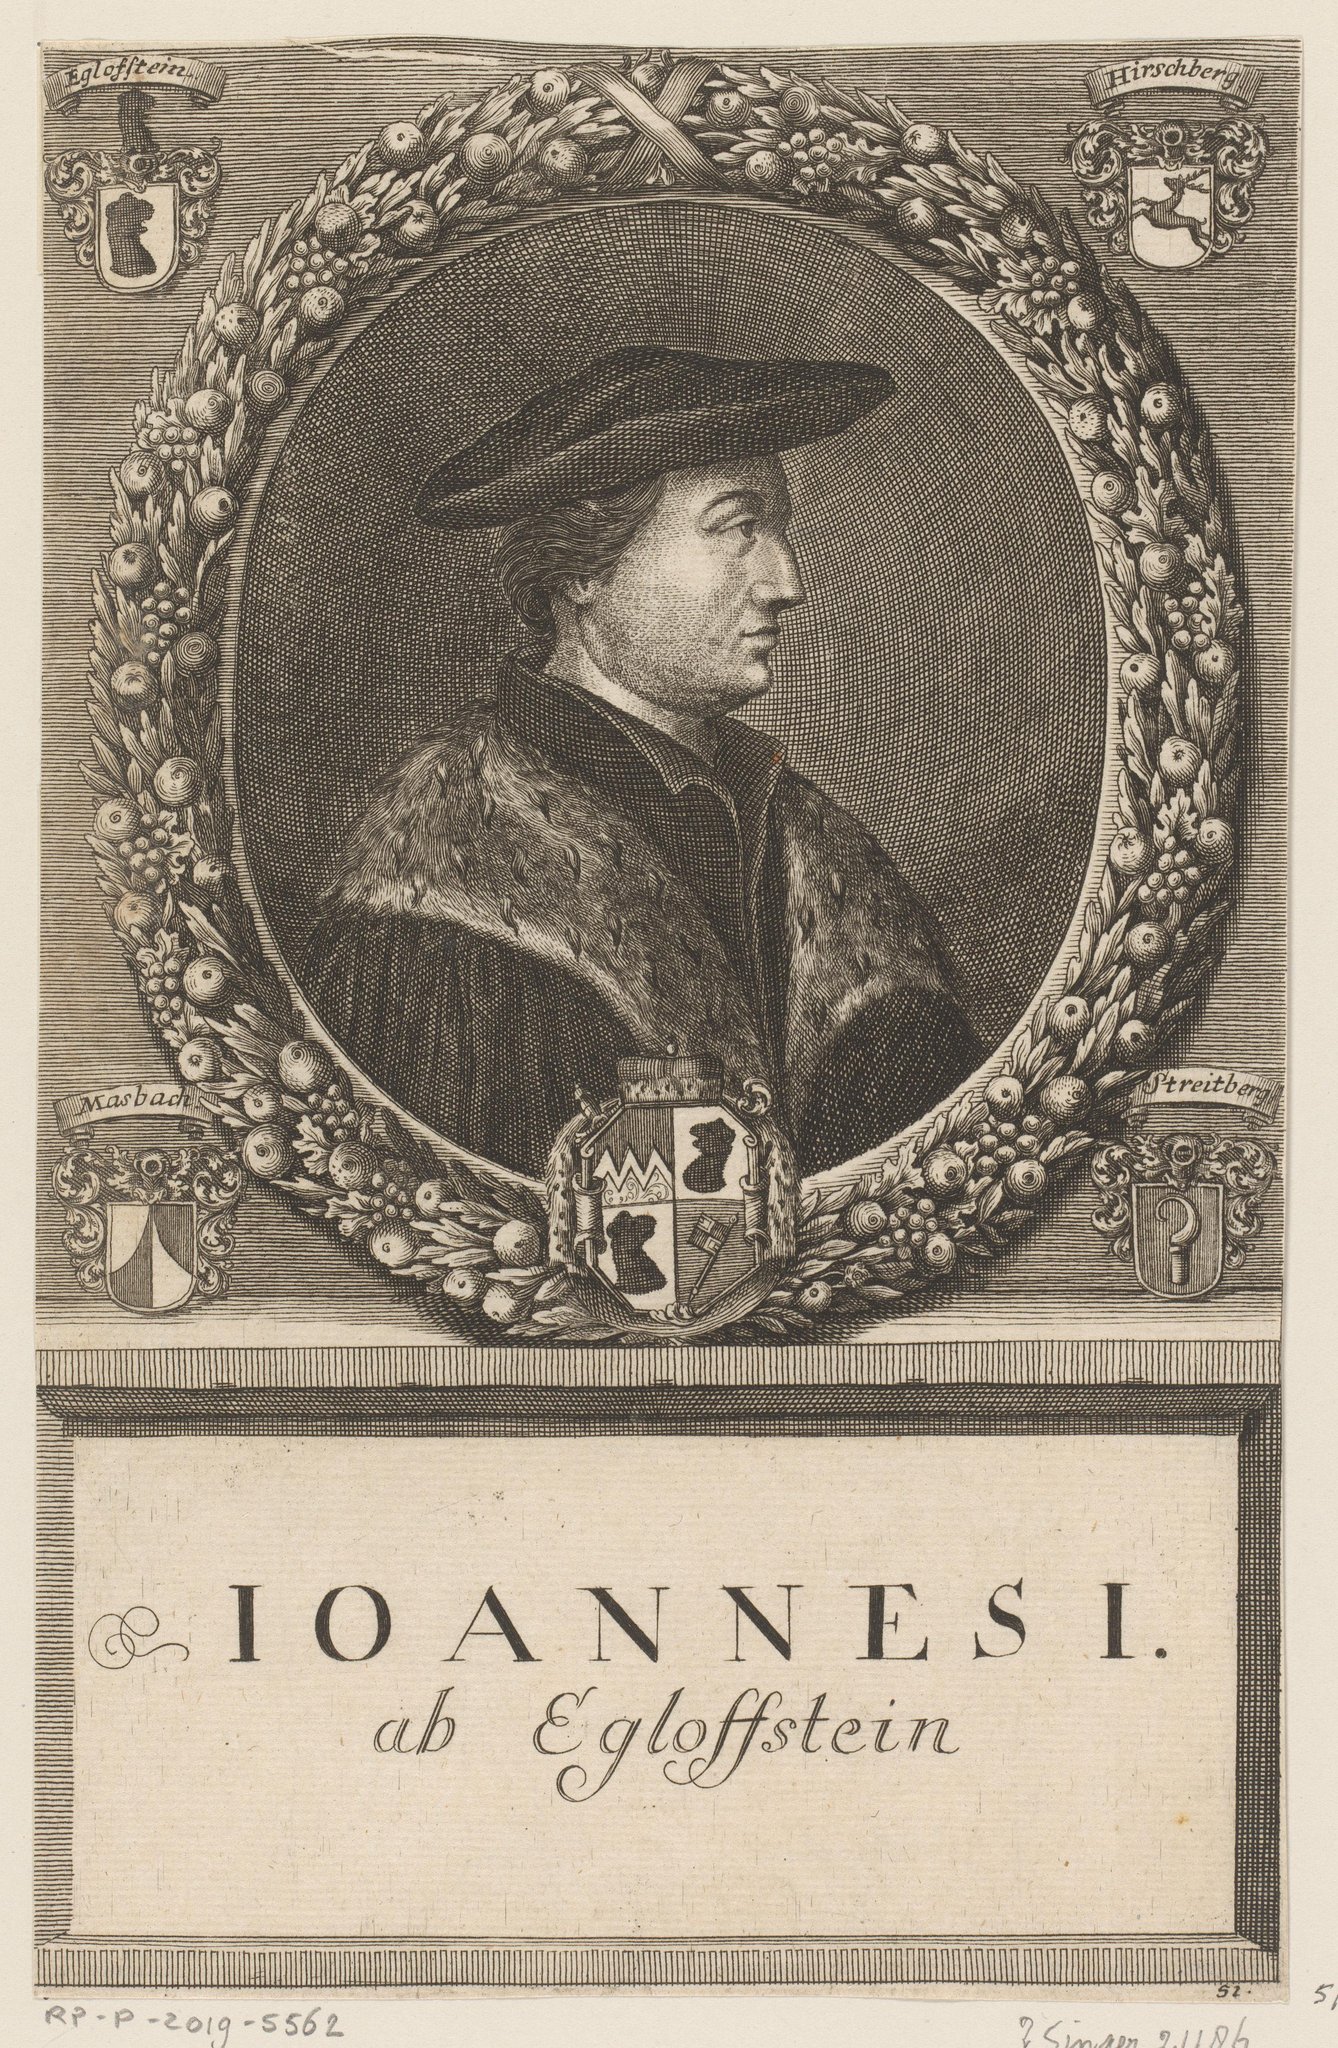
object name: print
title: Portret van Johann I von Egloffstein, bisschop van Würzburg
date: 1713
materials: paper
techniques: engraving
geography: frankfurt am main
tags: archbishop, bishop, etc. (roman catholic), historical persons, armorial bearing, heraldry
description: Prent uit: Ludewig, Johann Peter von. Geschicht-Schreiber von dem Bischoffthum Wirtzburg (...). Frankfurt am Main: Thomas Fritsch, 1713.